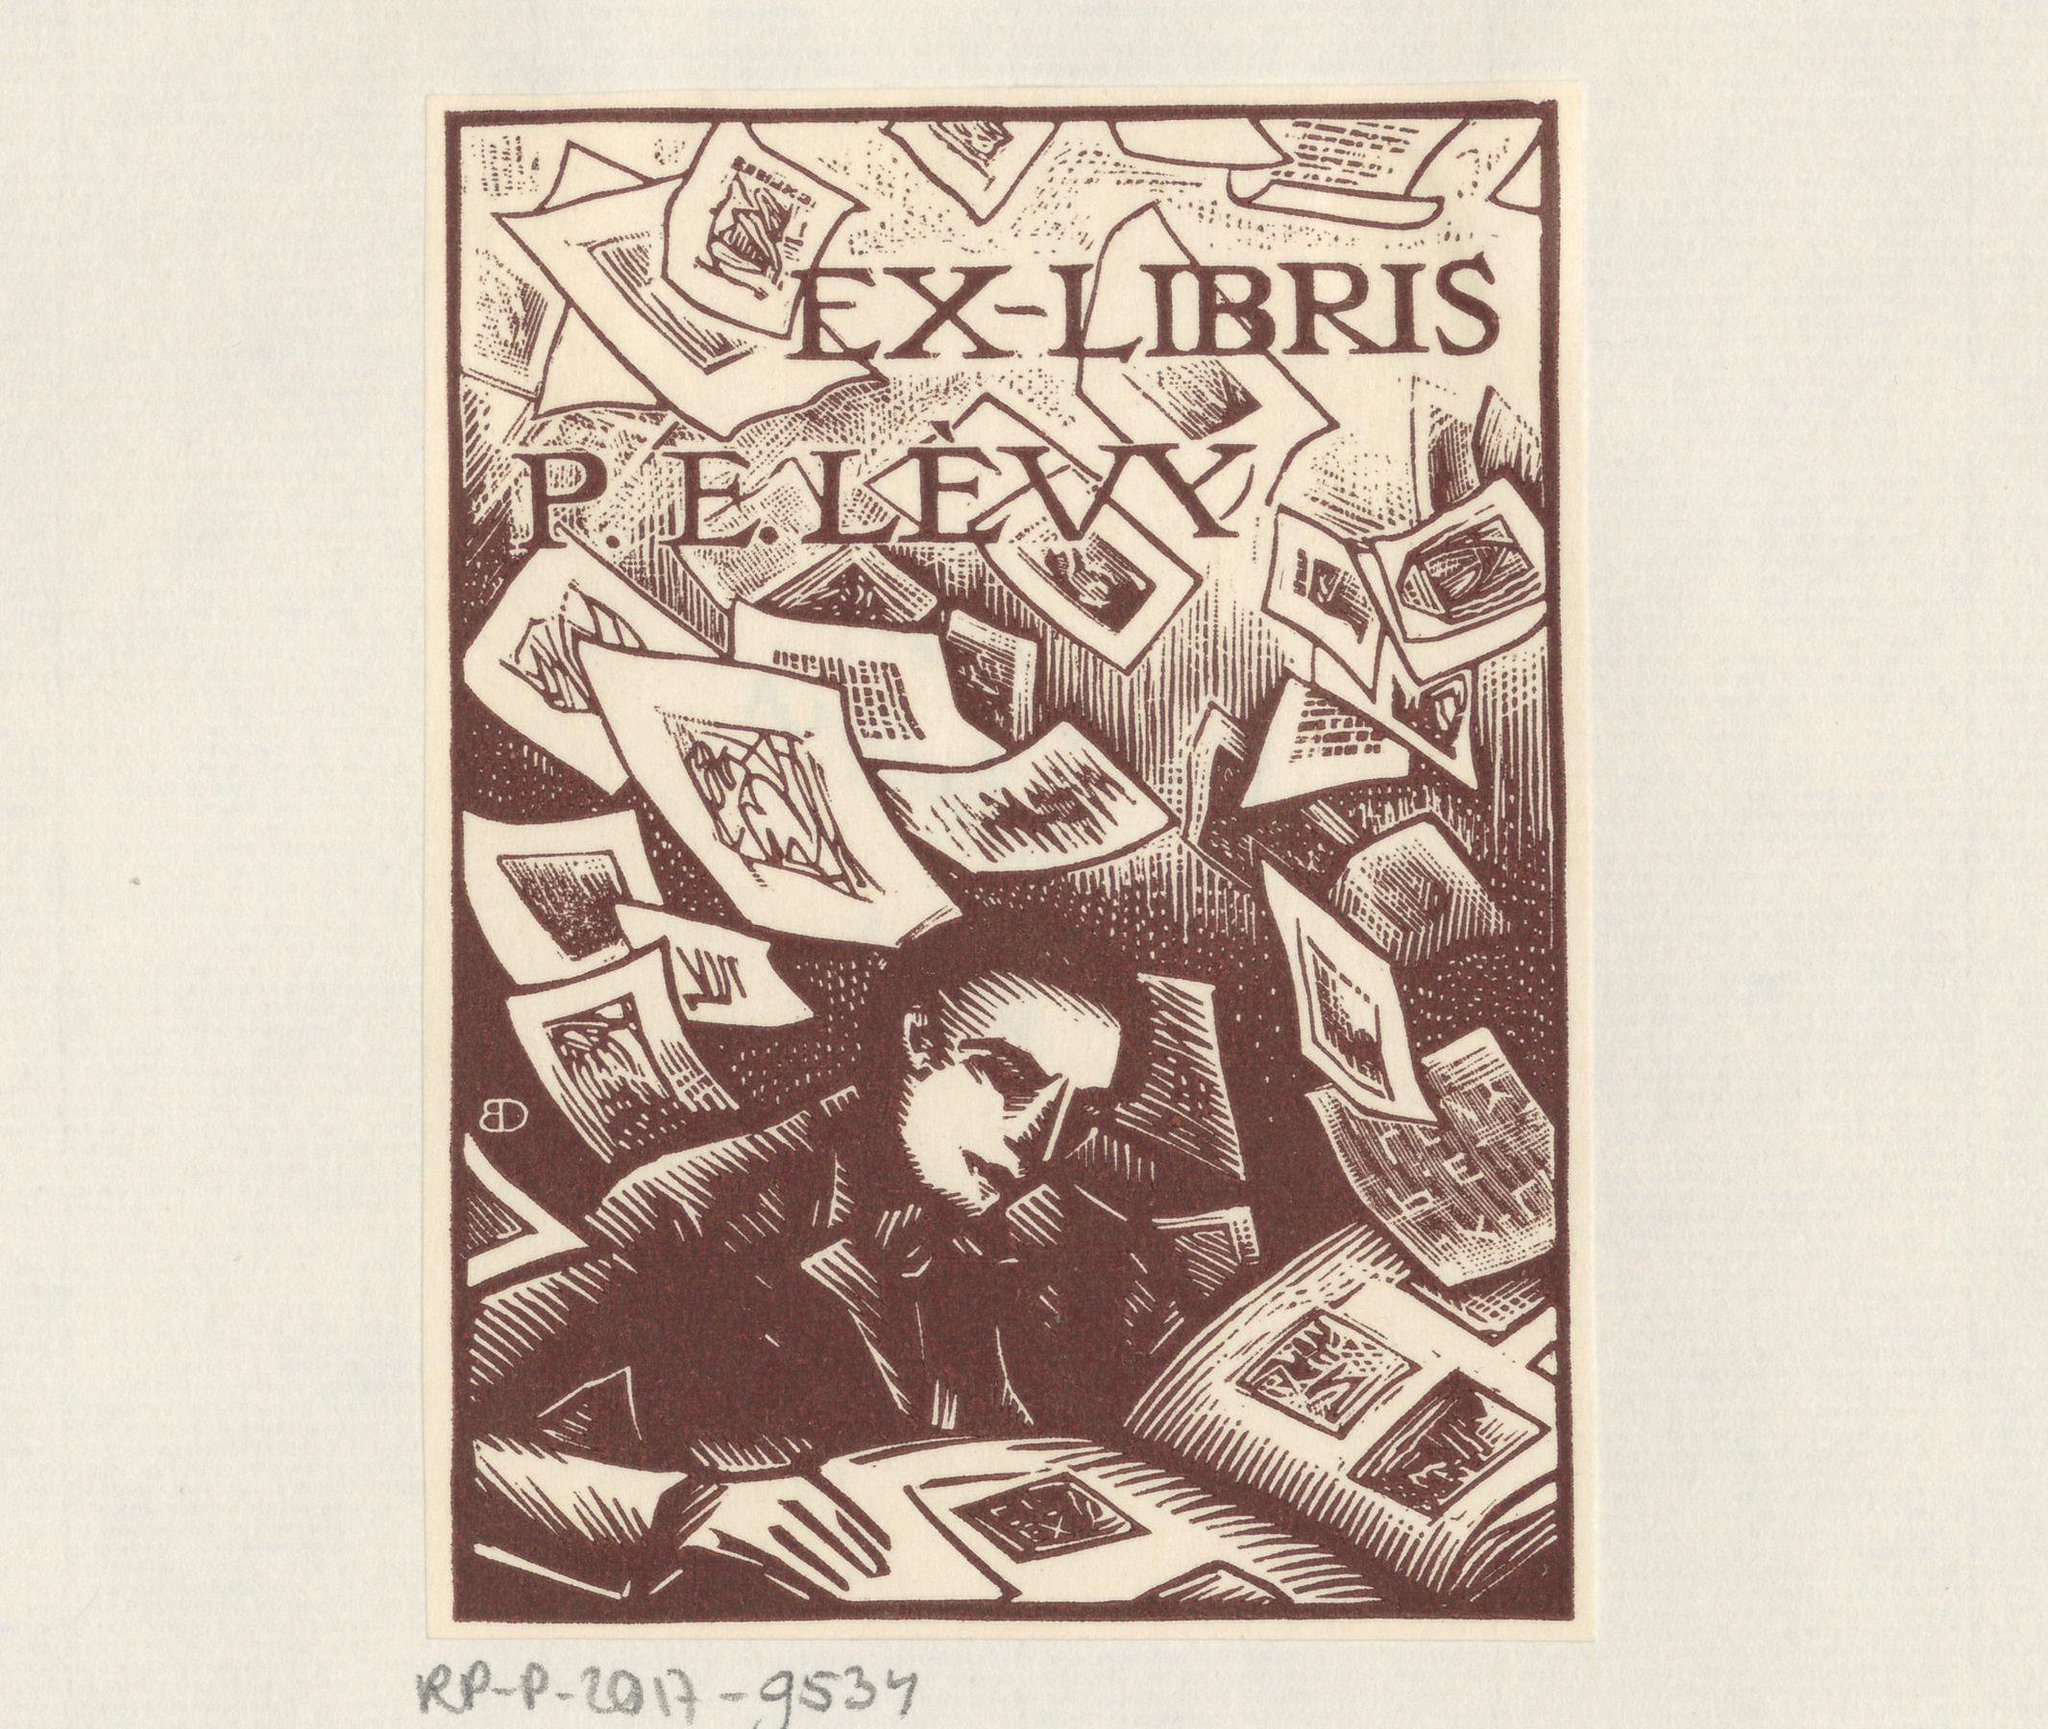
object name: bookplate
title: Ex libris van Pierre Edmond Lévy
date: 1920-1969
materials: paper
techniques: woodcut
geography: paris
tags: collecting (leisure time activity), sitting figure, printed matter